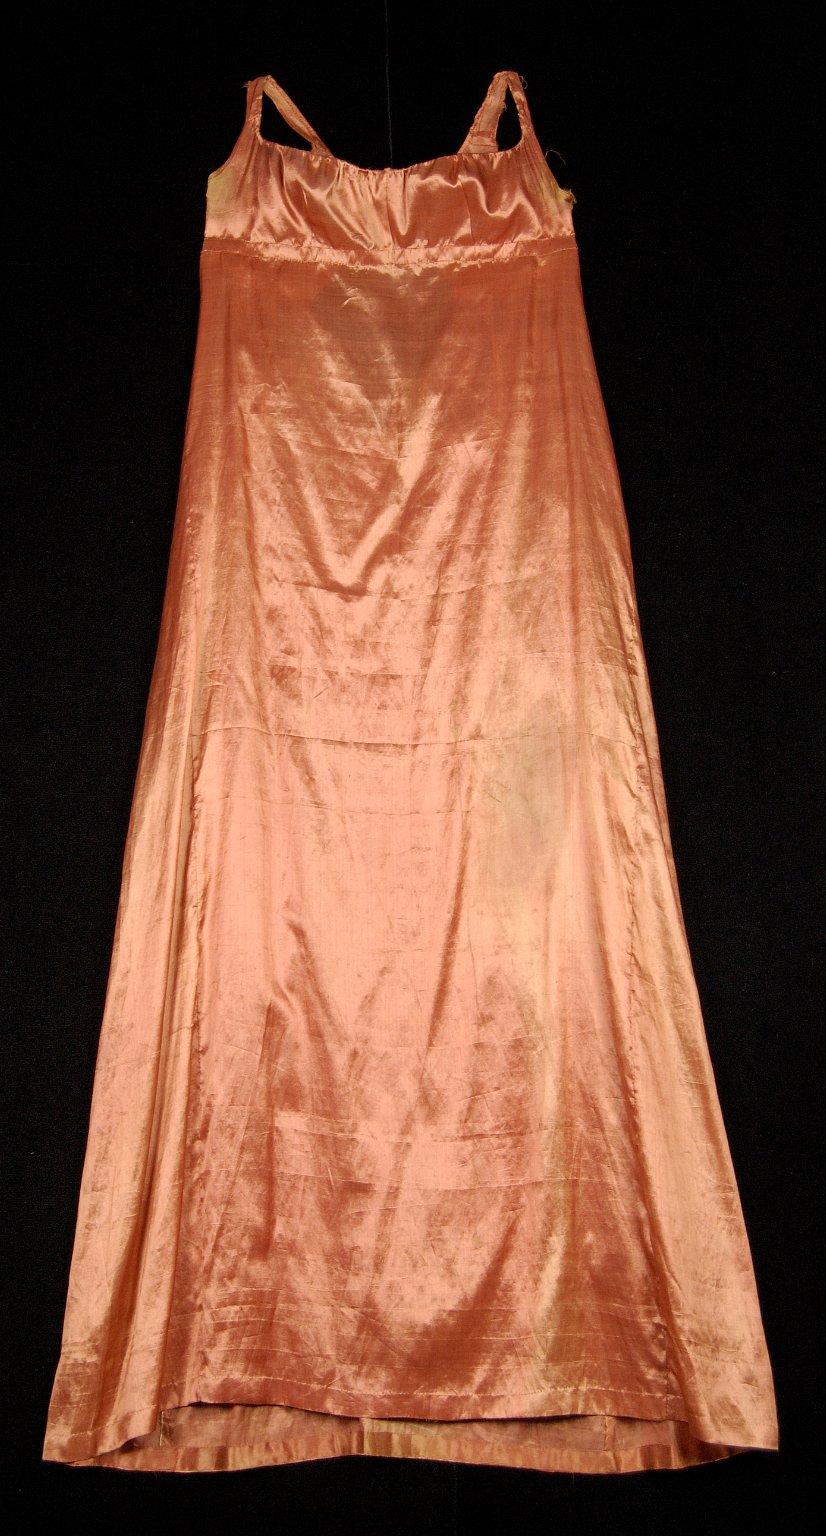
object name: underdress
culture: british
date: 1805-1810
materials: silk